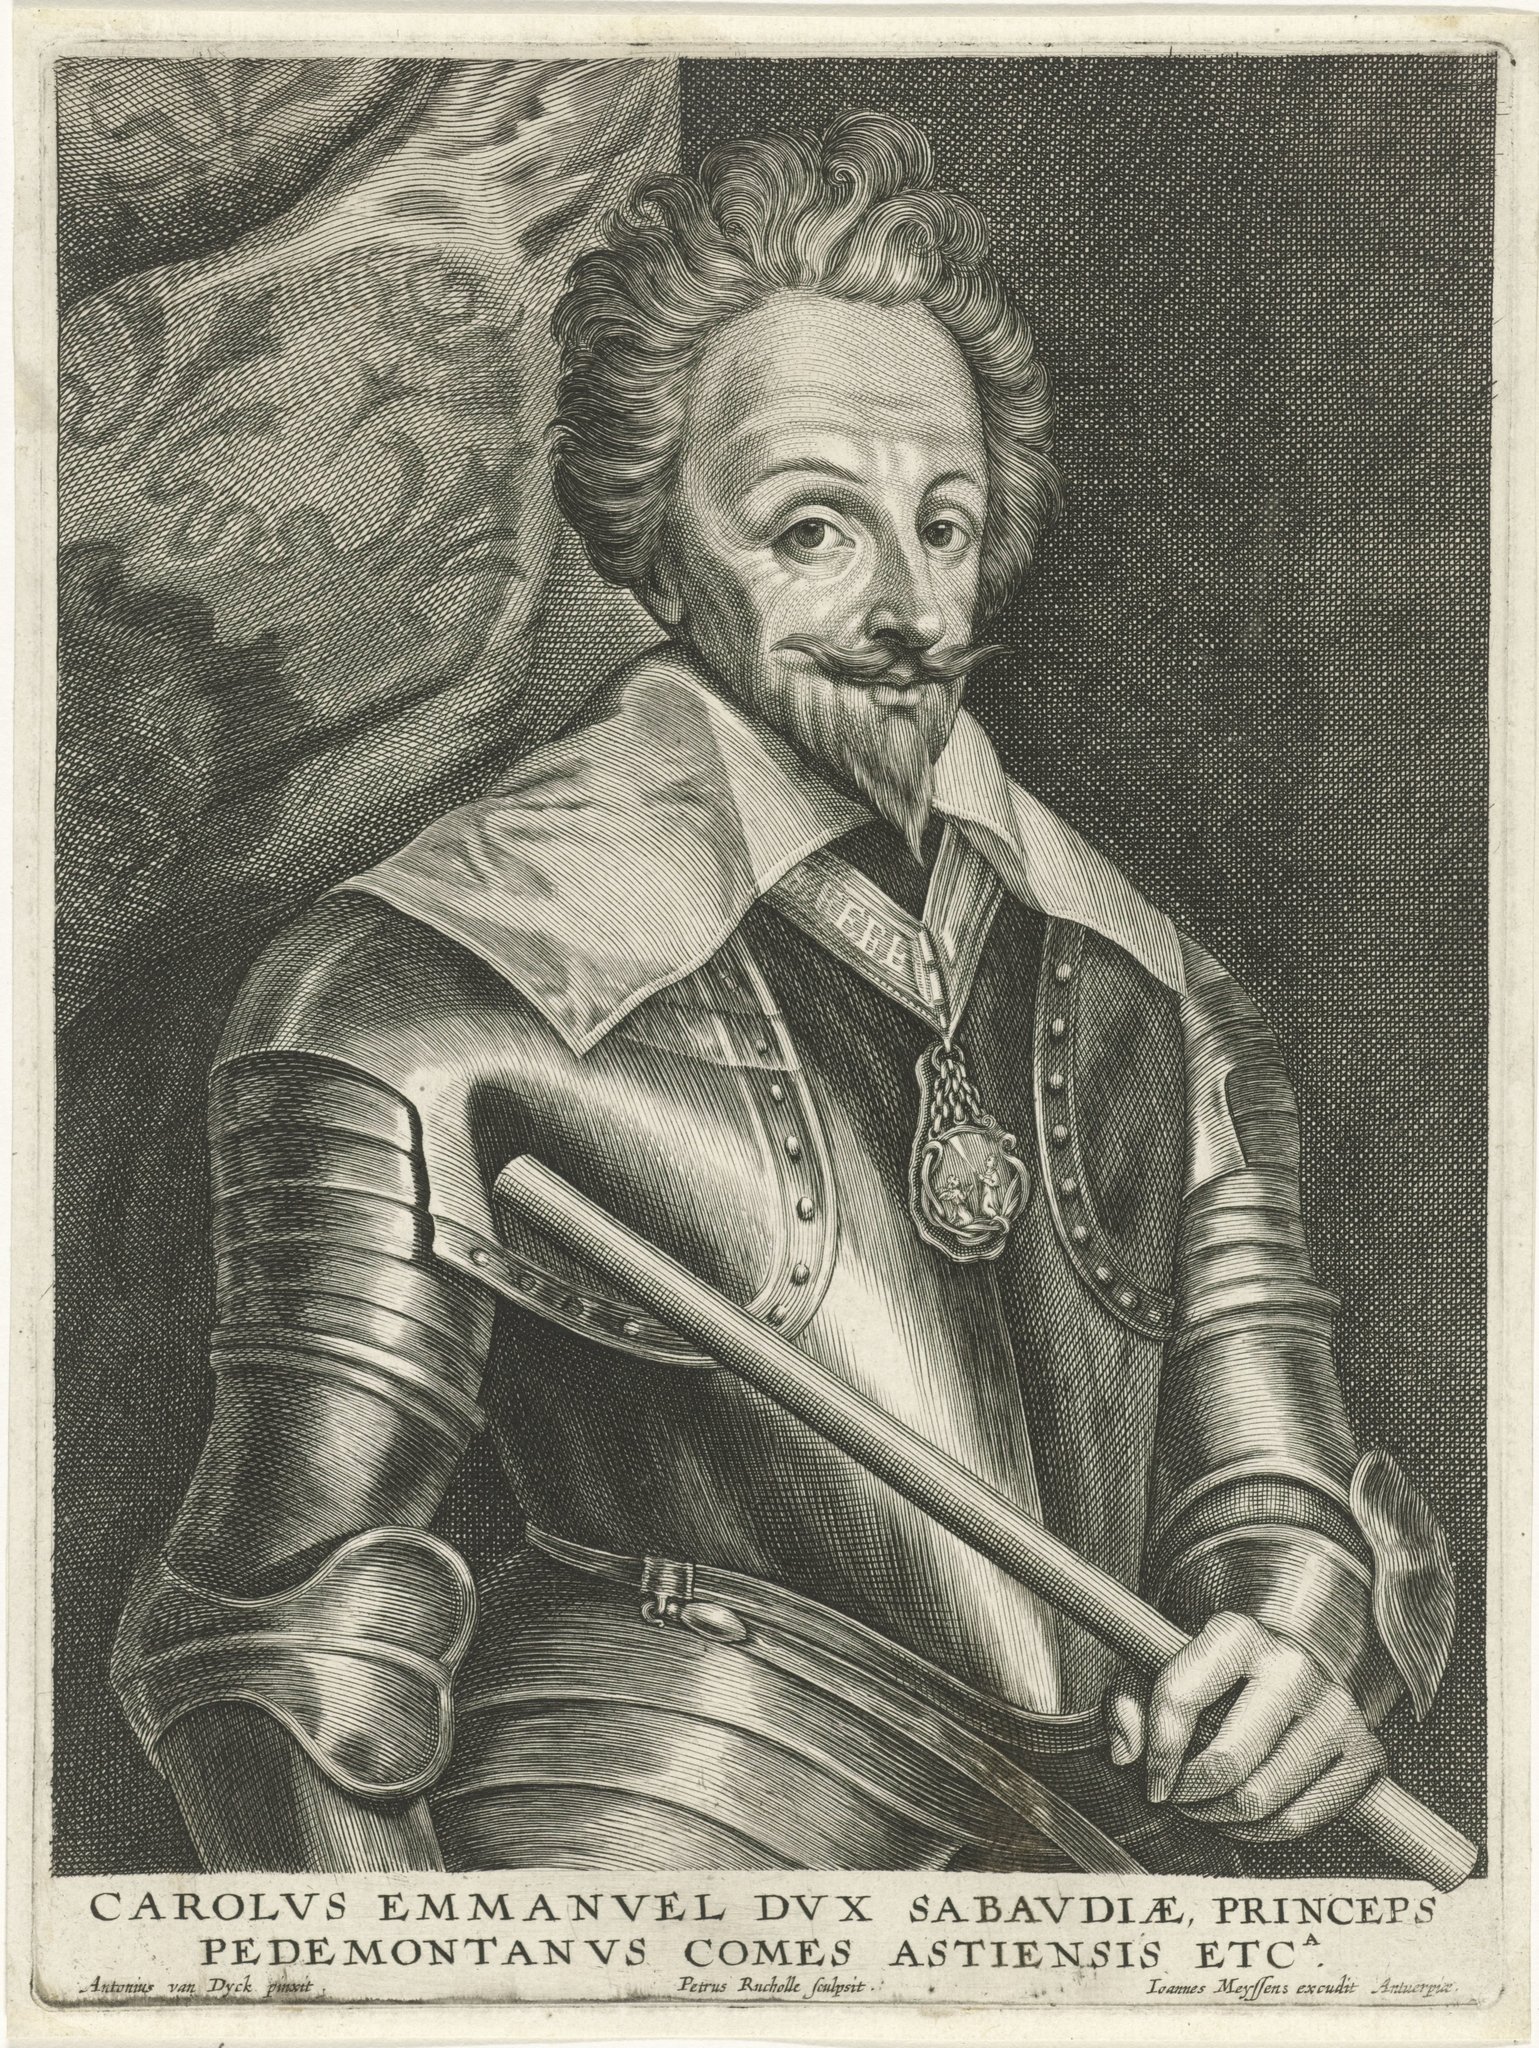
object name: print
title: Portret van Karel Emanuel I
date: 1640-1670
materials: paper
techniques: engraving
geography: antwerp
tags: karel emanuel i (hertog van savoye)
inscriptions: collector's mark: Lugt 240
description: Portret van Karel Emanuel I, hertog van Savoye. Hij is gekleed in een harnas en heeft een stok in de hand.